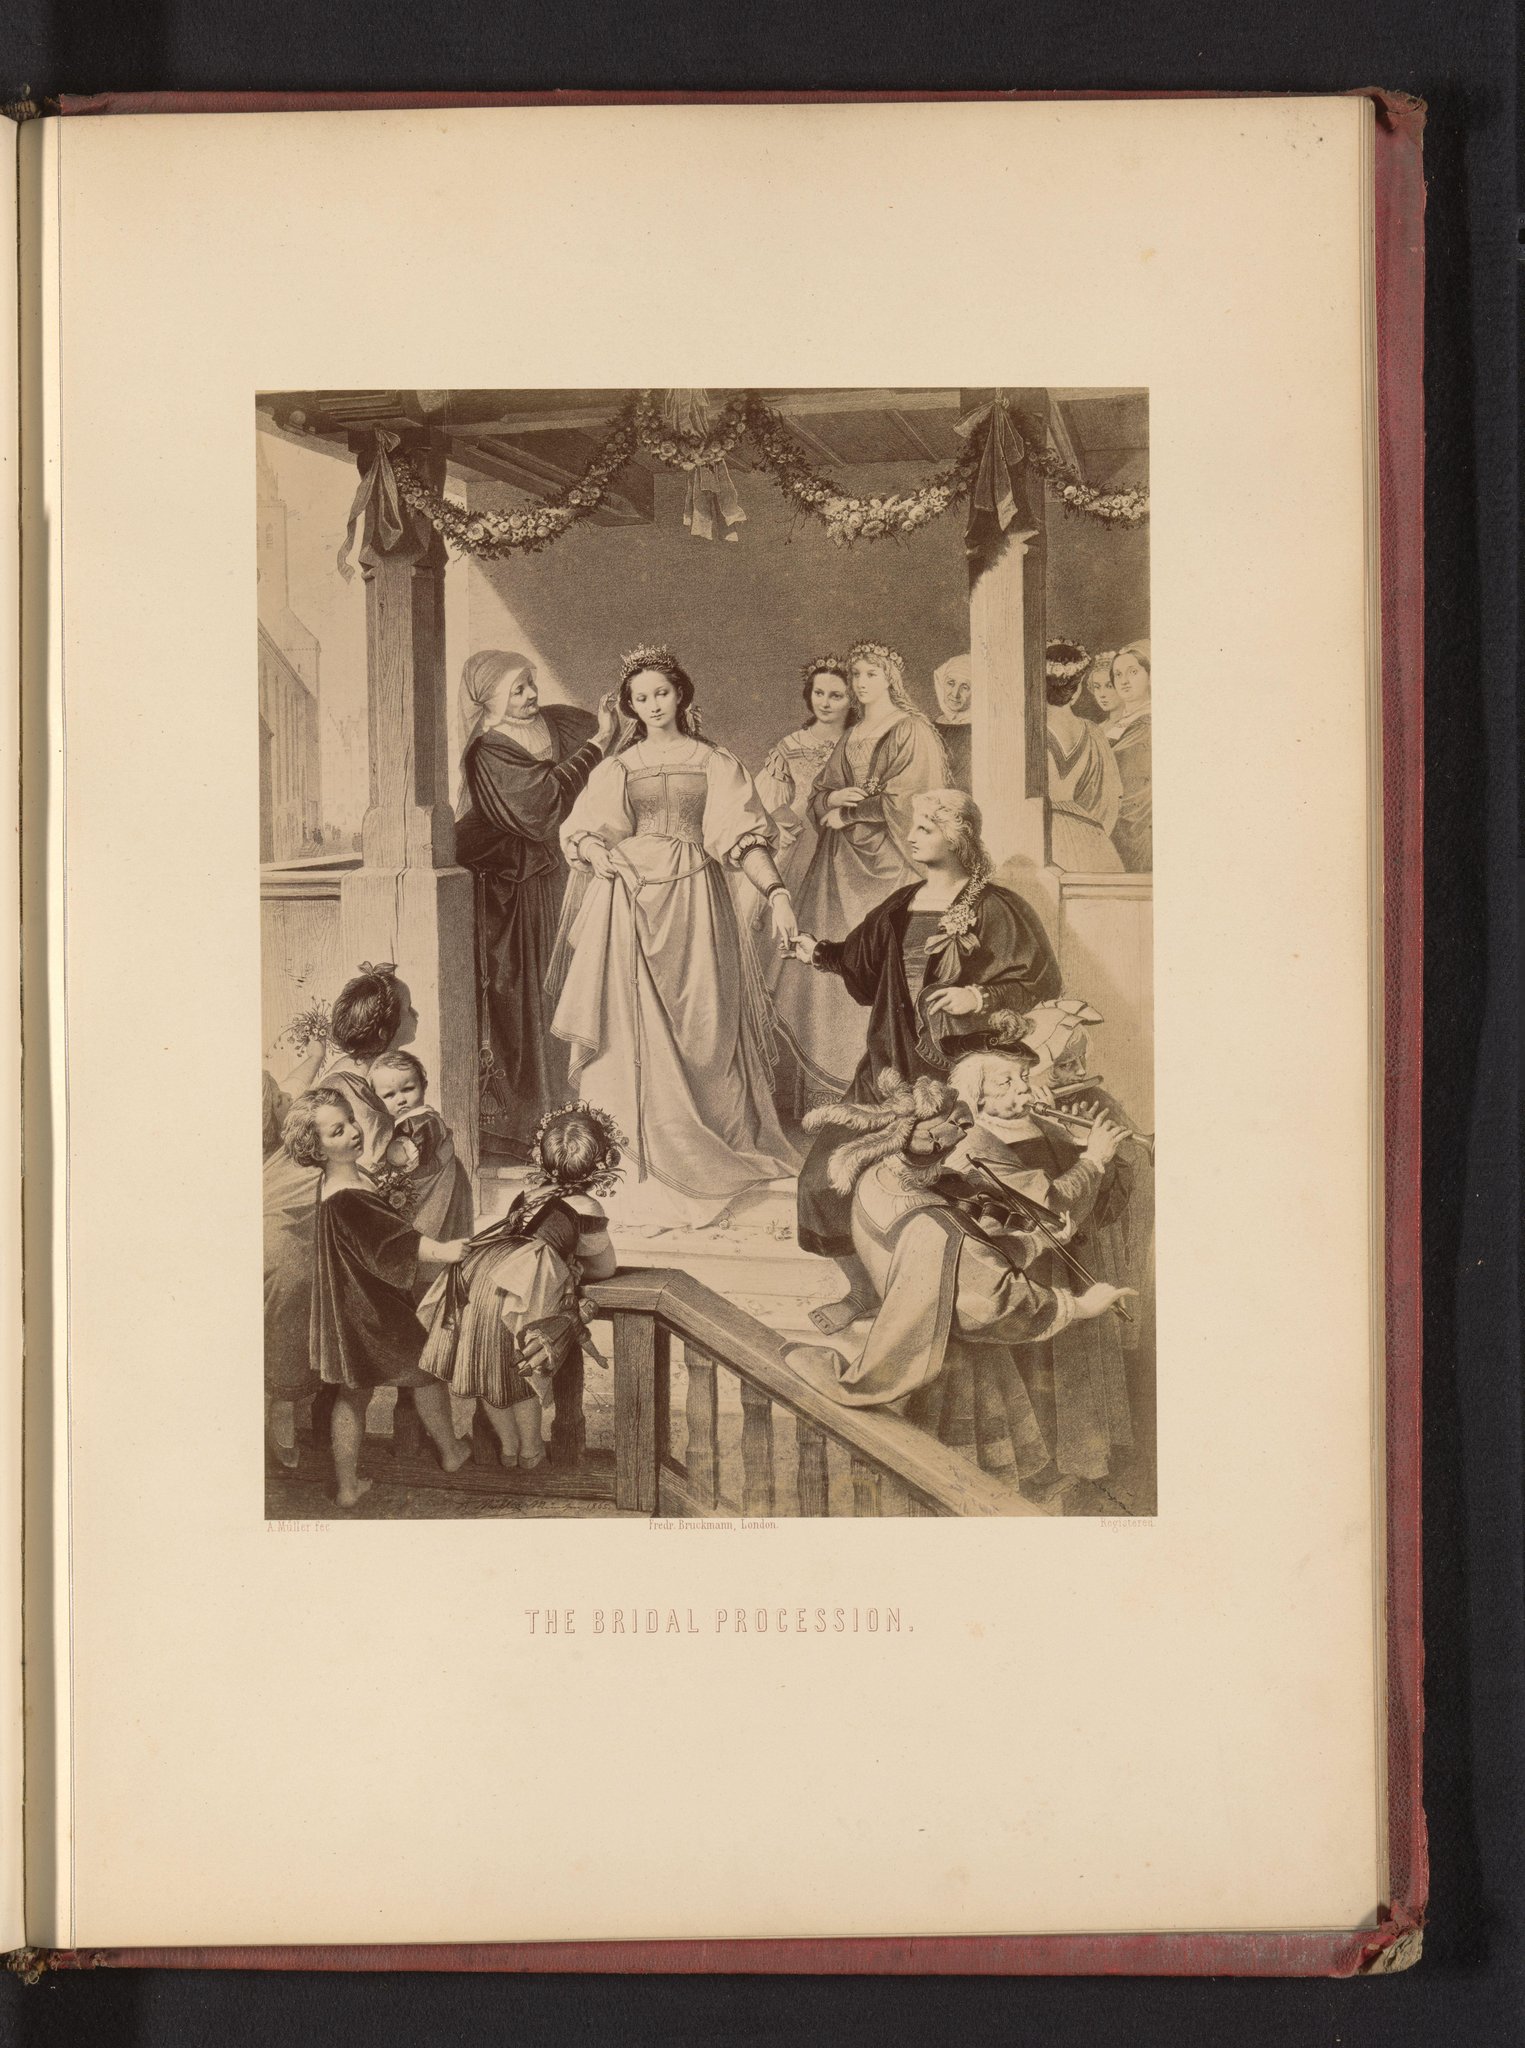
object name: page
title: The Bridal Procession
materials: photographic support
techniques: albumen print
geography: london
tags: meeting of bride and groom; groom calling for bride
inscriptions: inscription: ‘Registered.’